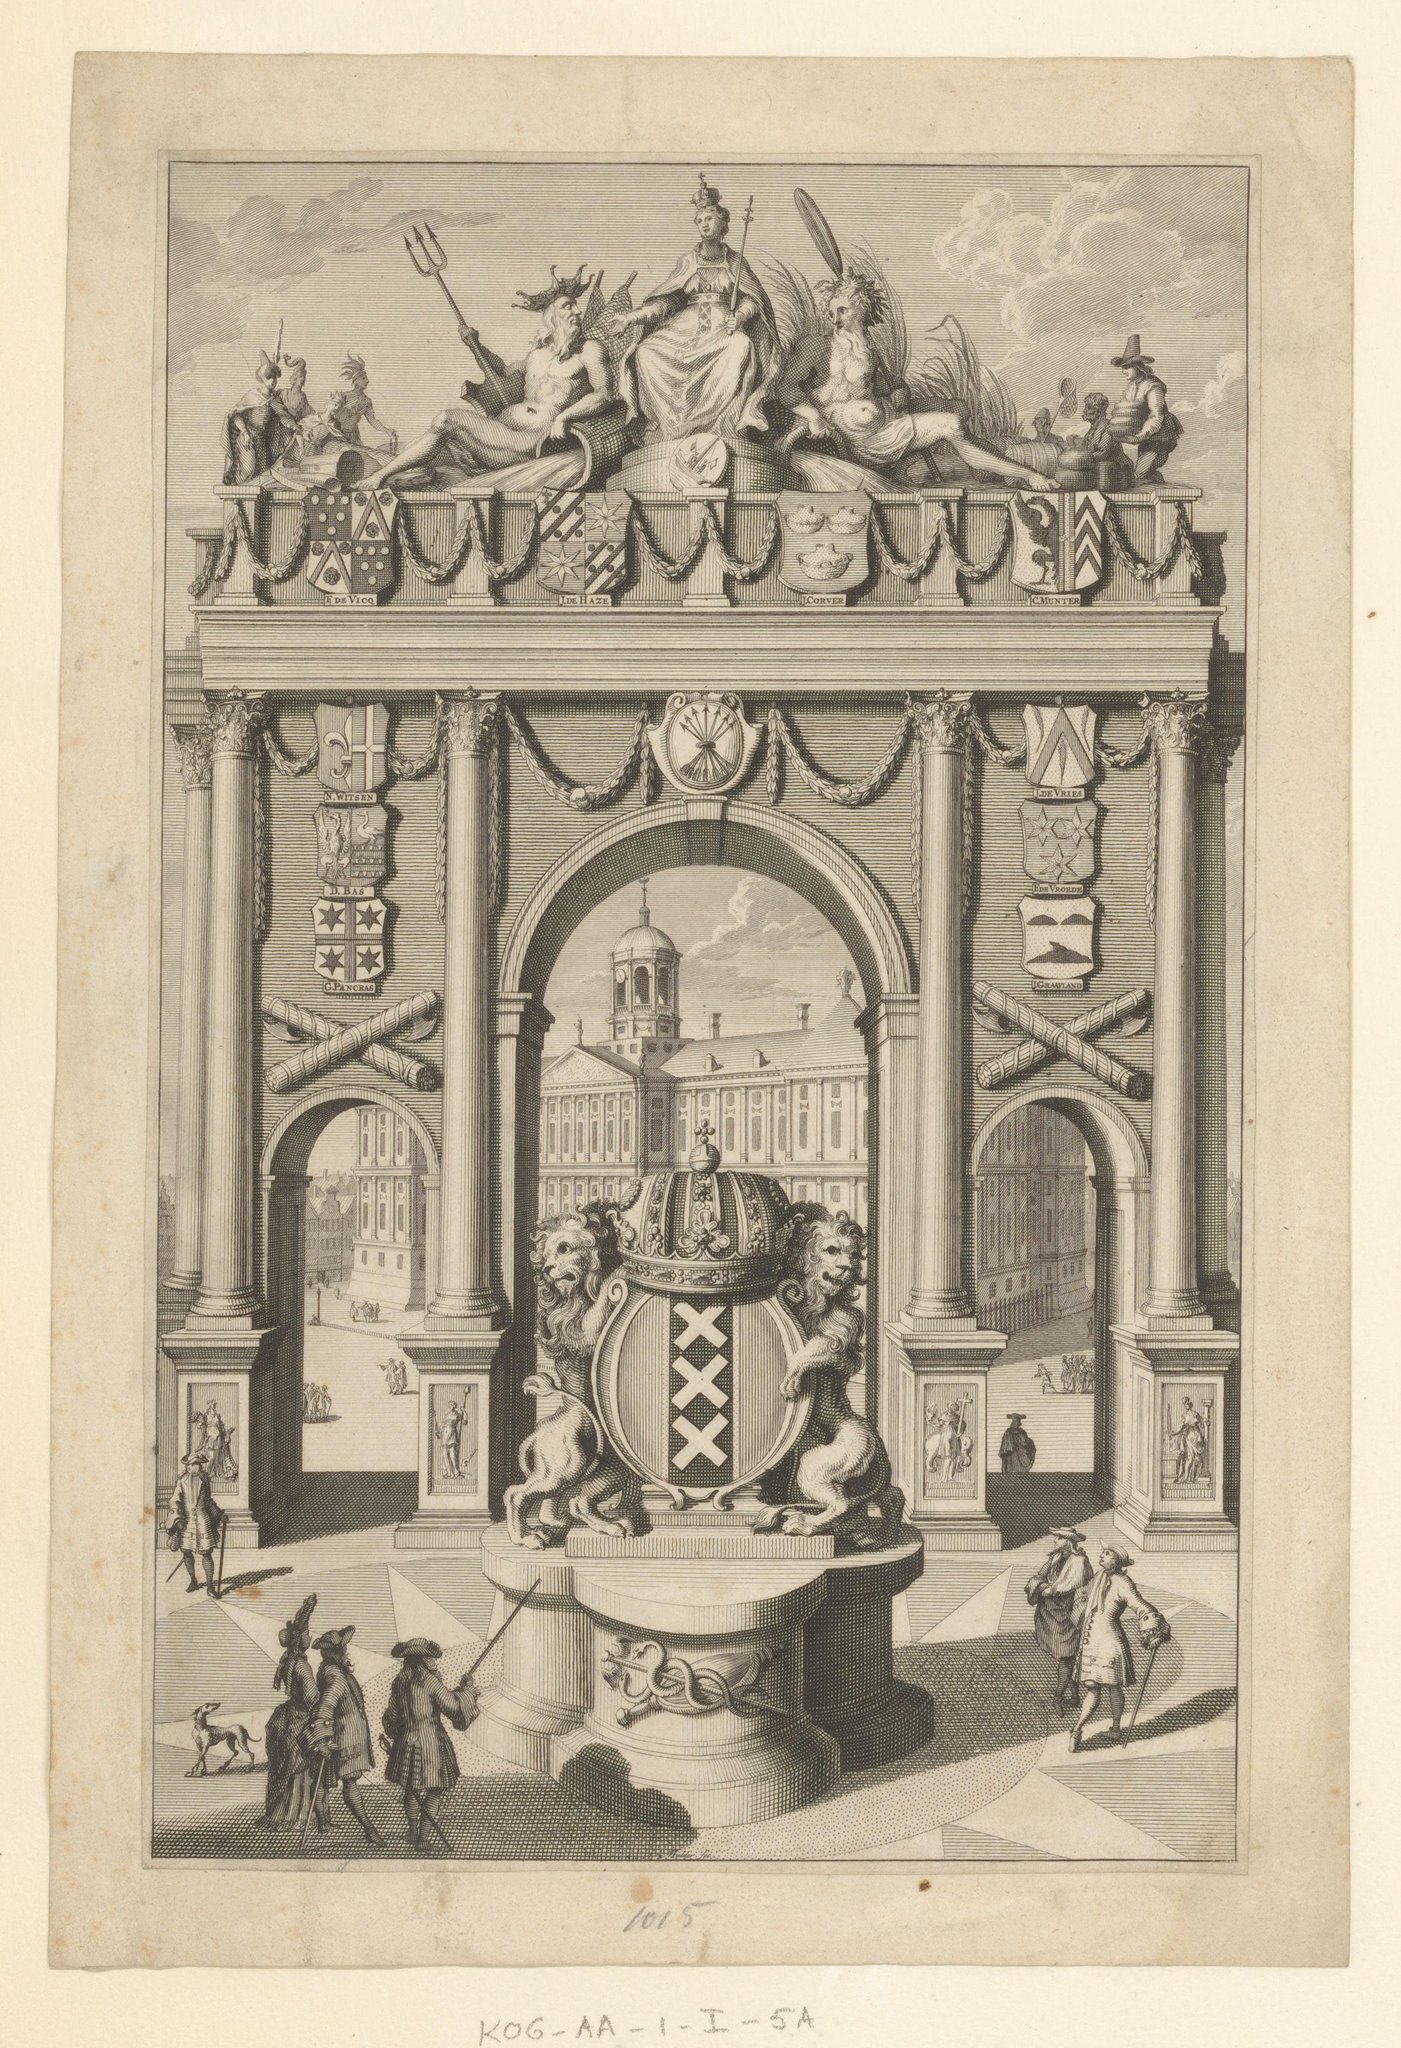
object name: print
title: Triomfboog op de Dam, met wapenschilden van enkele Amsterdamse burgemeesters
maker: Anonymous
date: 1700-1799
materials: paper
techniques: engraving, etching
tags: politician, print maker, nicolaes cornelisz. witsen, amsterdam, mayor, jeronimo de haze, city-view in general; 'veduta', triumphal arch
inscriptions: collector's mark: ‘1A’ Lugt 1641b, inscription: ‘Legaat Joh. M. Coffeng / 1966’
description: Onderwerpsrubriek binnen de Atlas Amsterdam: Titels en voorberichten.